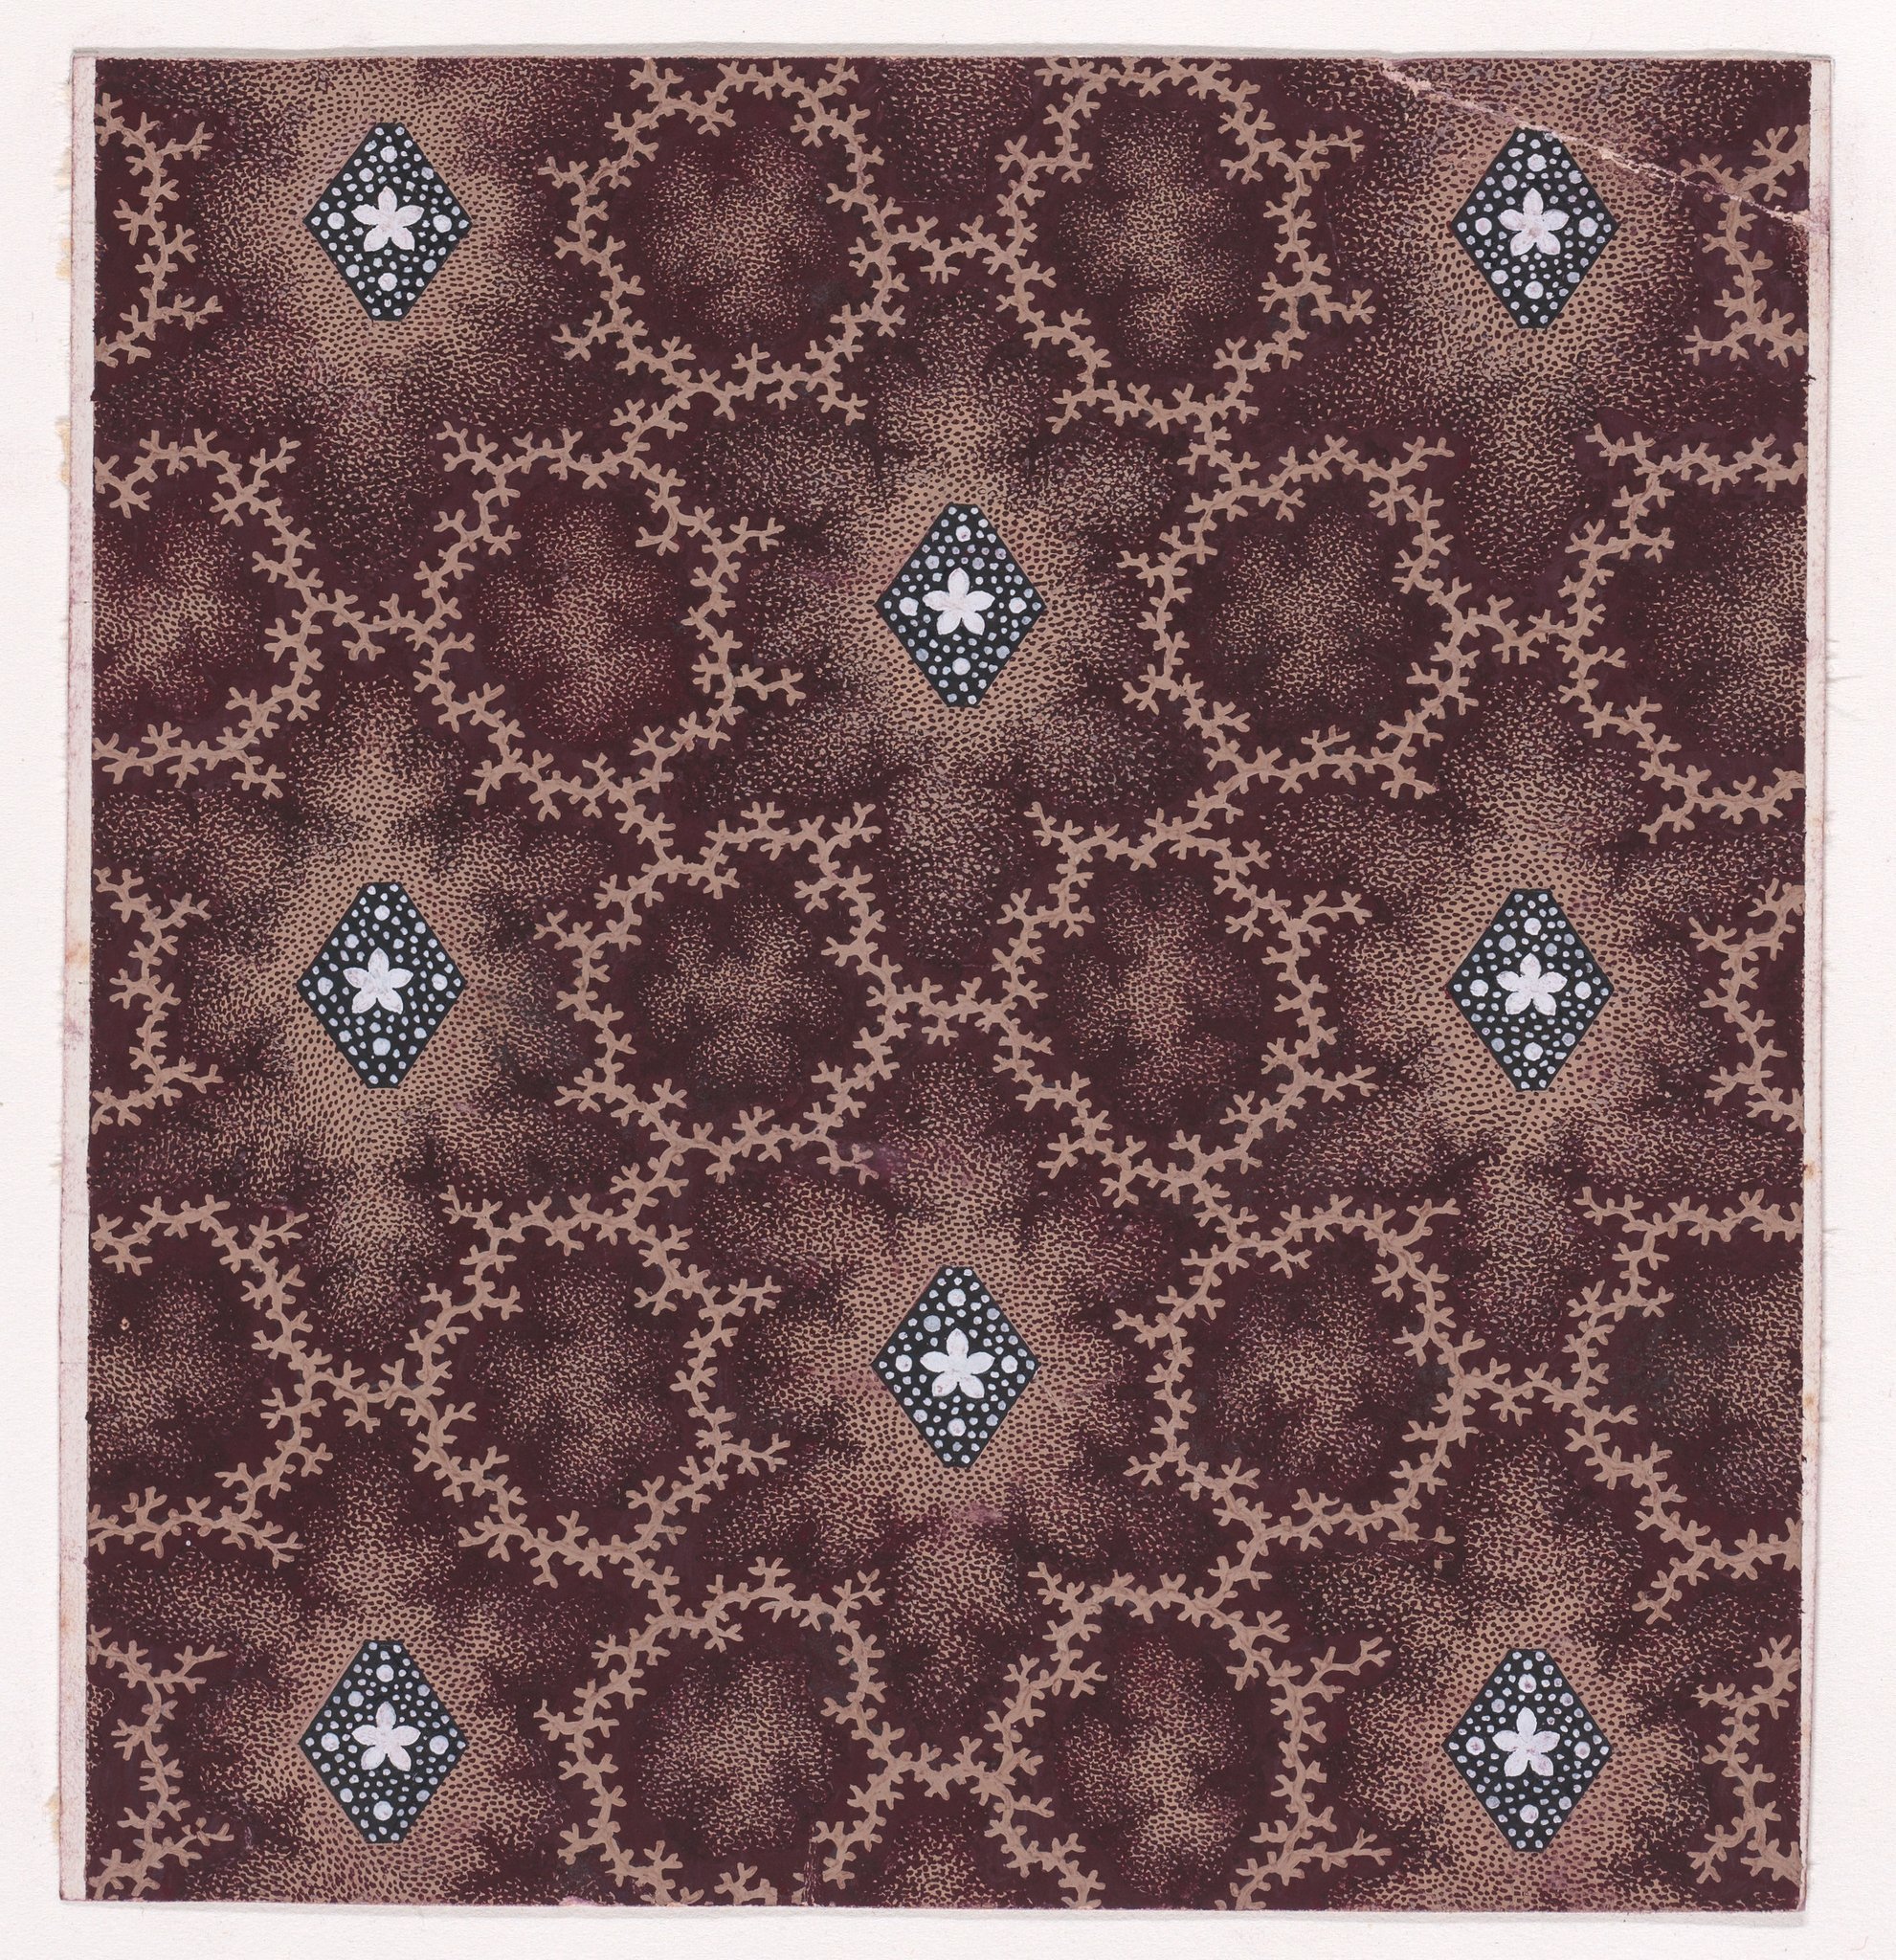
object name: drawing ornament architecture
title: Textile Design with Alternating Vertical Rows of Lozenges Decorated with Rosettes and Pearls Framed by Interlacing Garlands of Branches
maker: anonymous, alsatian, 19th century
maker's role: artist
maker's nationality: alsatian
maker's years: 1800-1900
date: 1840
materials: gouache